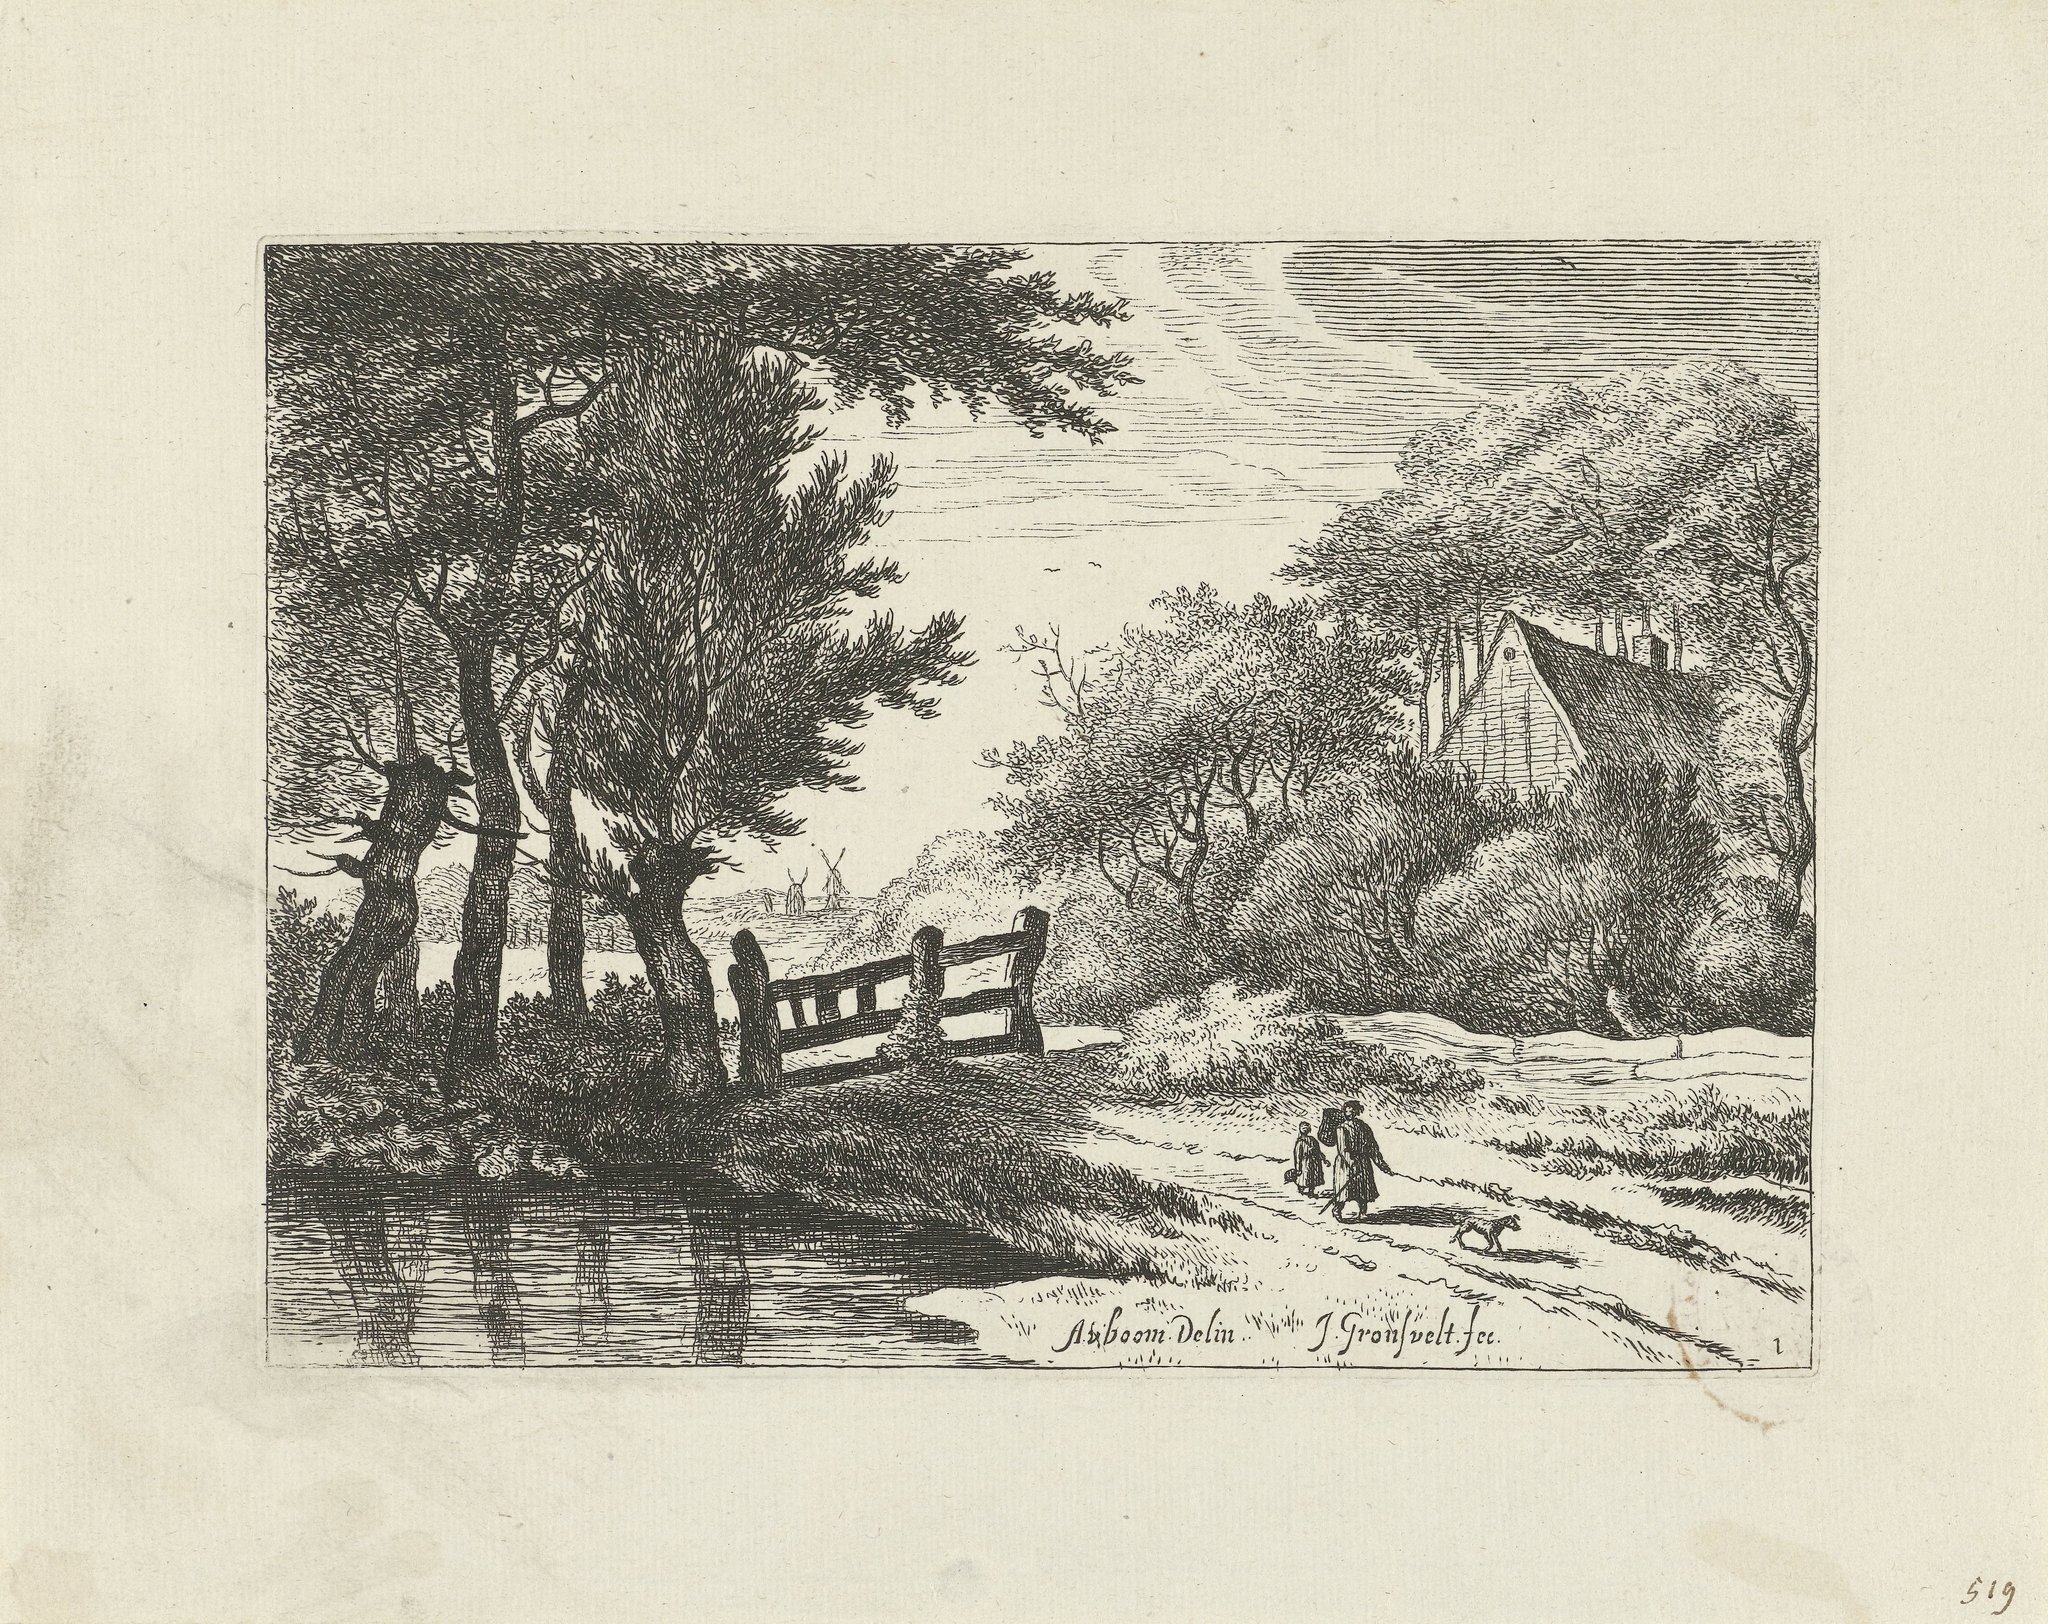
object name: print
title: Landschappen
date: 1679-1728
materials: paper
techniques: engraving, etching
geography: amsterdam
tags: landscapes (+ landscape with figures, staffage), dog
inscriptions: collector's mark: Lugt 240, inscription: ‘519’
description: Landschap met twee wandelaars en een hond op een landweg. Links op de voorgrond bomen aan een meer en op de achtergrond twee molens. Eerste prent uit een serie van zes met landschappen.